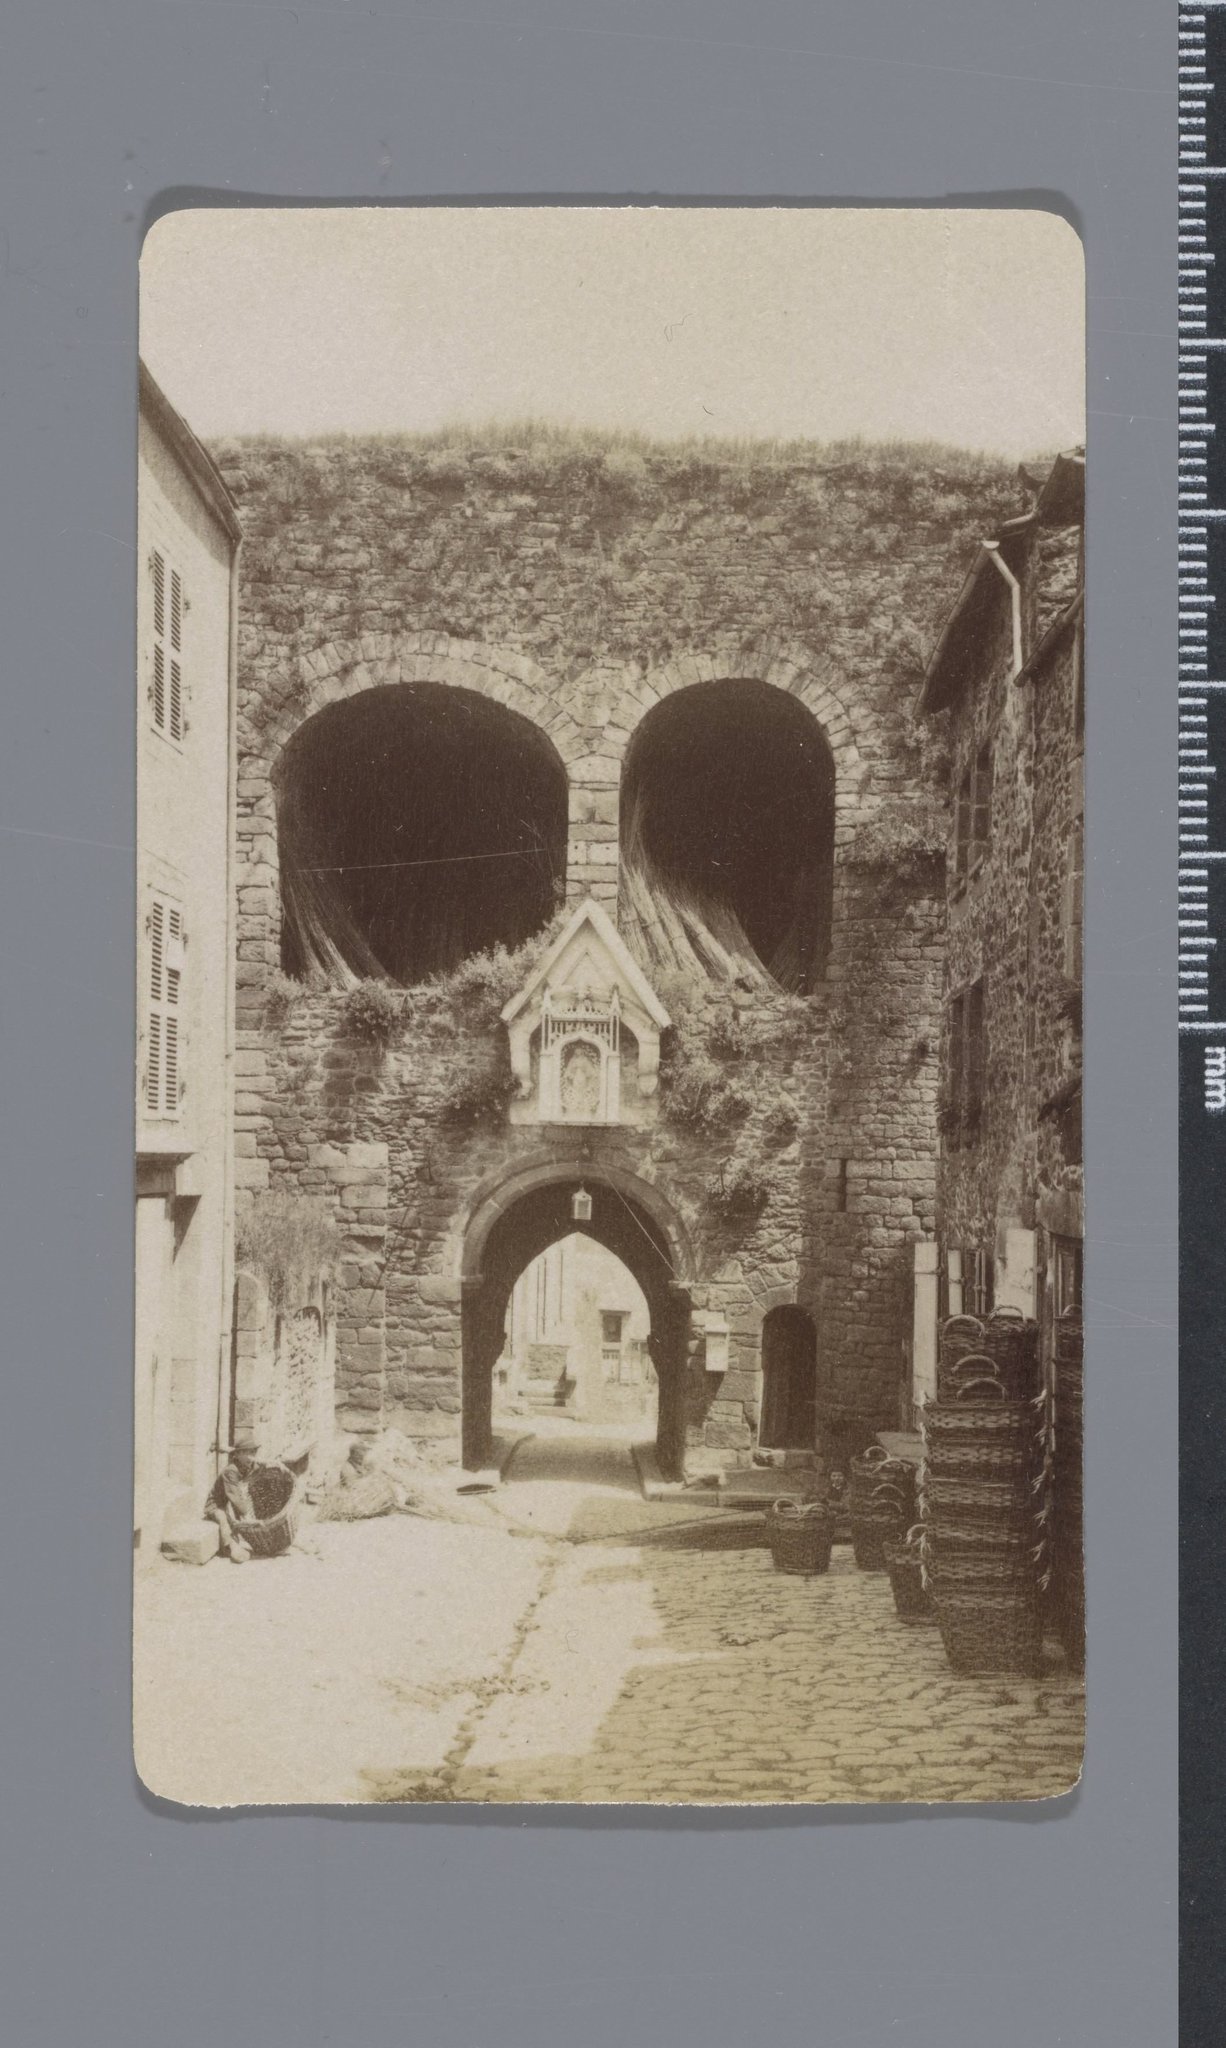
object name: photograph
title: Gezicht op de Porte du Jerzual te Dinan, Frankrijk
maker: Anonymous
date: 1851-1900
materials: paper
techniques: albumen print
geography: dinan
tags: city-gate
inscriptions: inscription: ‘Dinan, la porte de Jerzual’